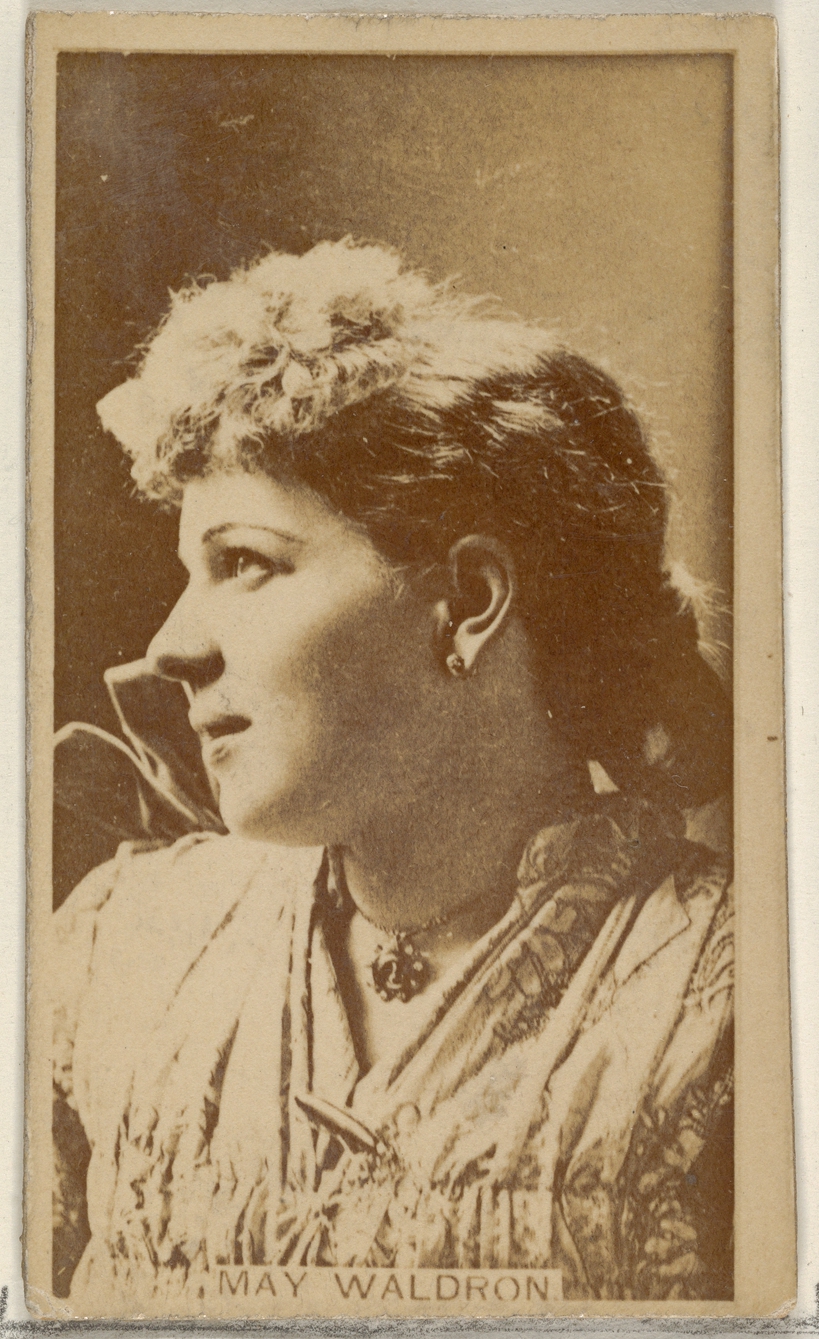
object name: photograph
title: May Waldron, from the Actors and Actresses series (N45, Type 8) for Virginia Brights Cigarettes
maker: allen & ginter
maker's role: publisher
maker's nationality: american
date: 1888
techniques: albumen silver print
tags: portraits,women,actresses